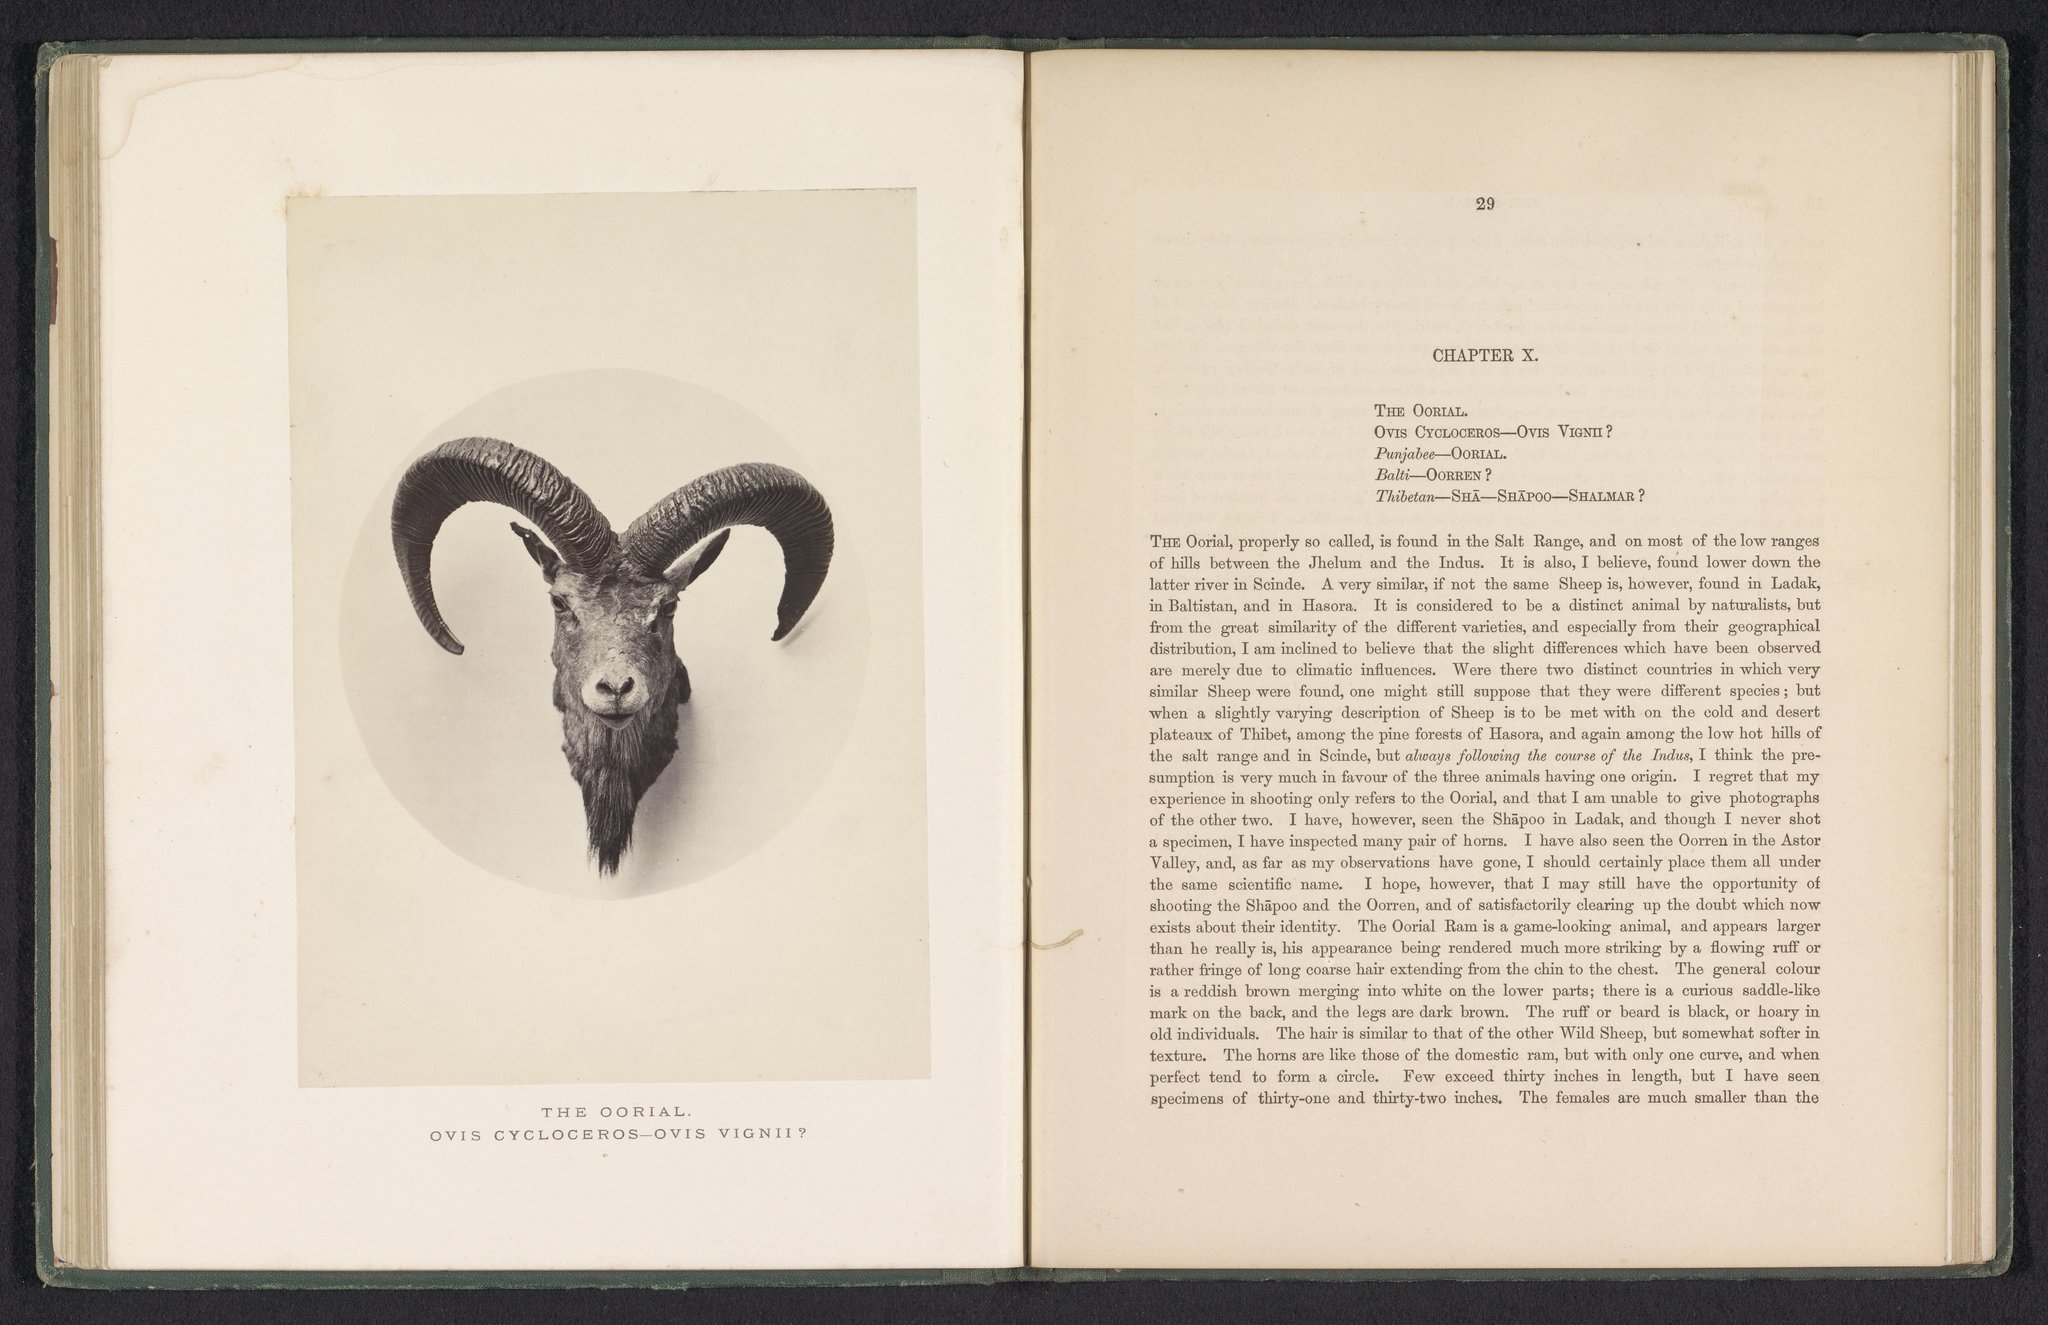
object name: page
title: The oorial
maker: arthur lucas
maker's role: fotograaf, handelaar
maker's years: 1842-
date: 1859-1869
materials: photographic support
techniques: albumen print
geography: london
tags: sheep